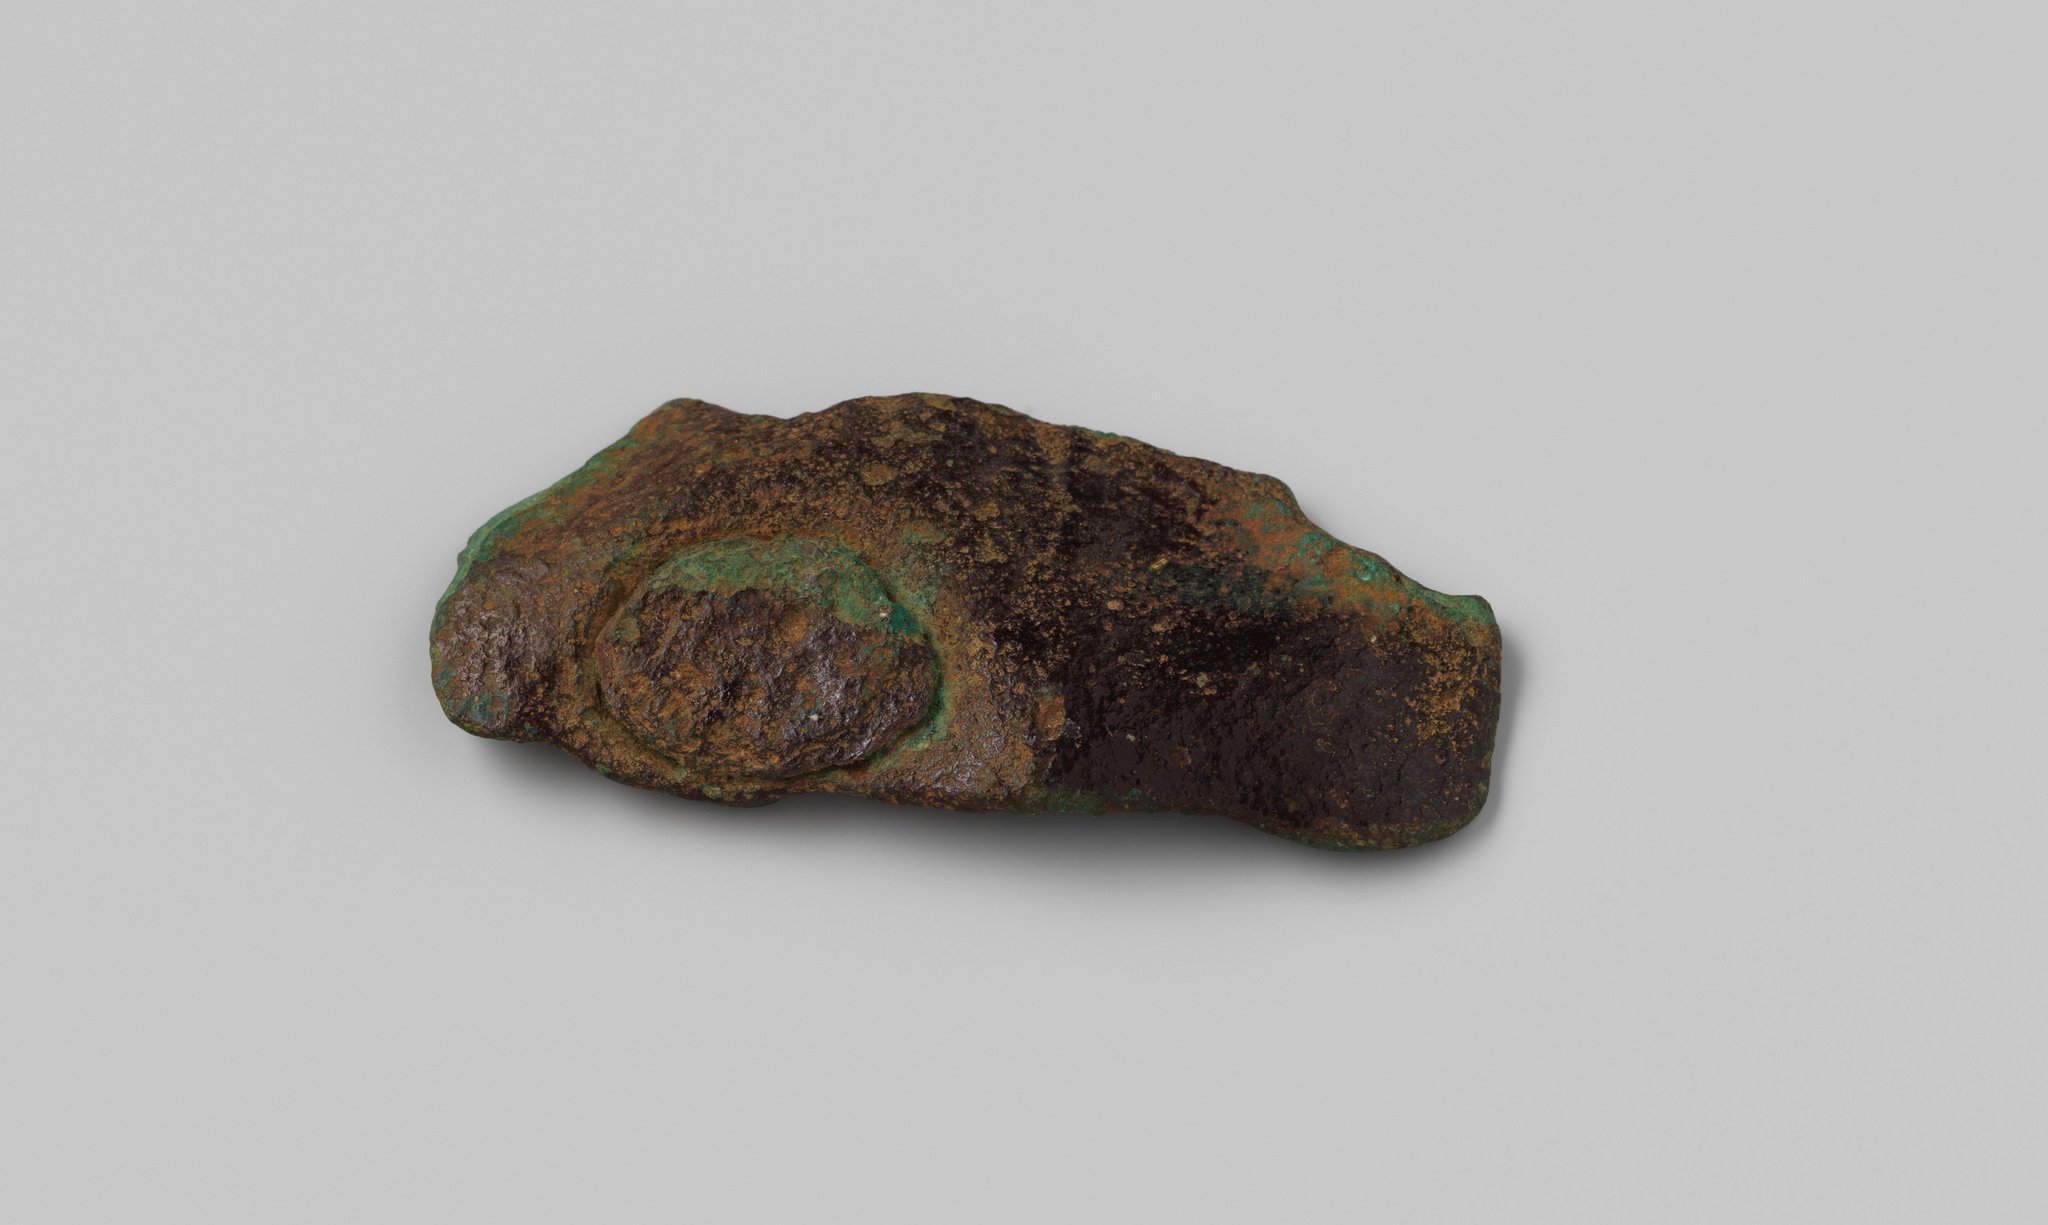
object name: fragment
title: Fragment koperen plaatwerk met klinknagel uit het wrak van de Oost-Indiëvaarder Hollandia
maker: Anonymous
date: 1700-1743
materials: copper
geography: netherlands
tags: verenigde oostindische compagnie, hollandia (schip), annet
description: Varied parts or fragments, sheet metal fragments: worked, with rivets; fragm, eroded, with 1 rivet, sim. 80H821.